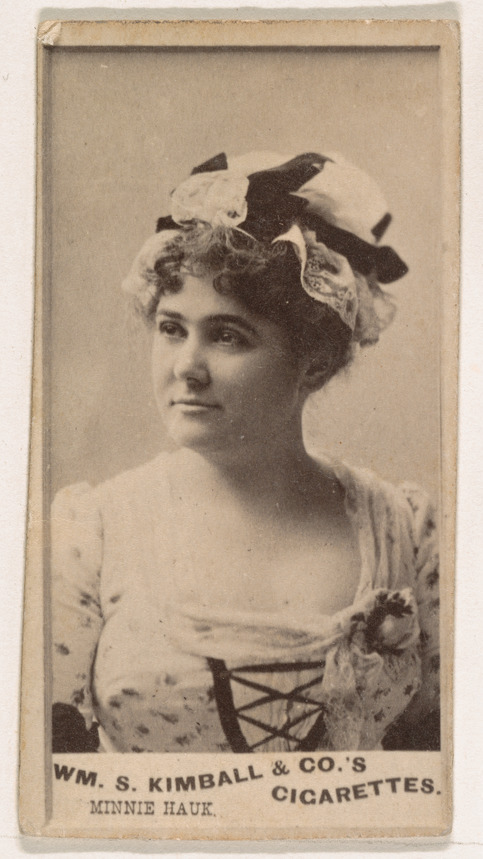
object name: photograph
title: Minnie Hauk, from the Actresses series (N203) issued by Wm. S. Kimball & Co.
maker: william s. kimball & company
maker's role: publisher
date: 1889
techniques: color lithograph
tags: portraits,women,actresses